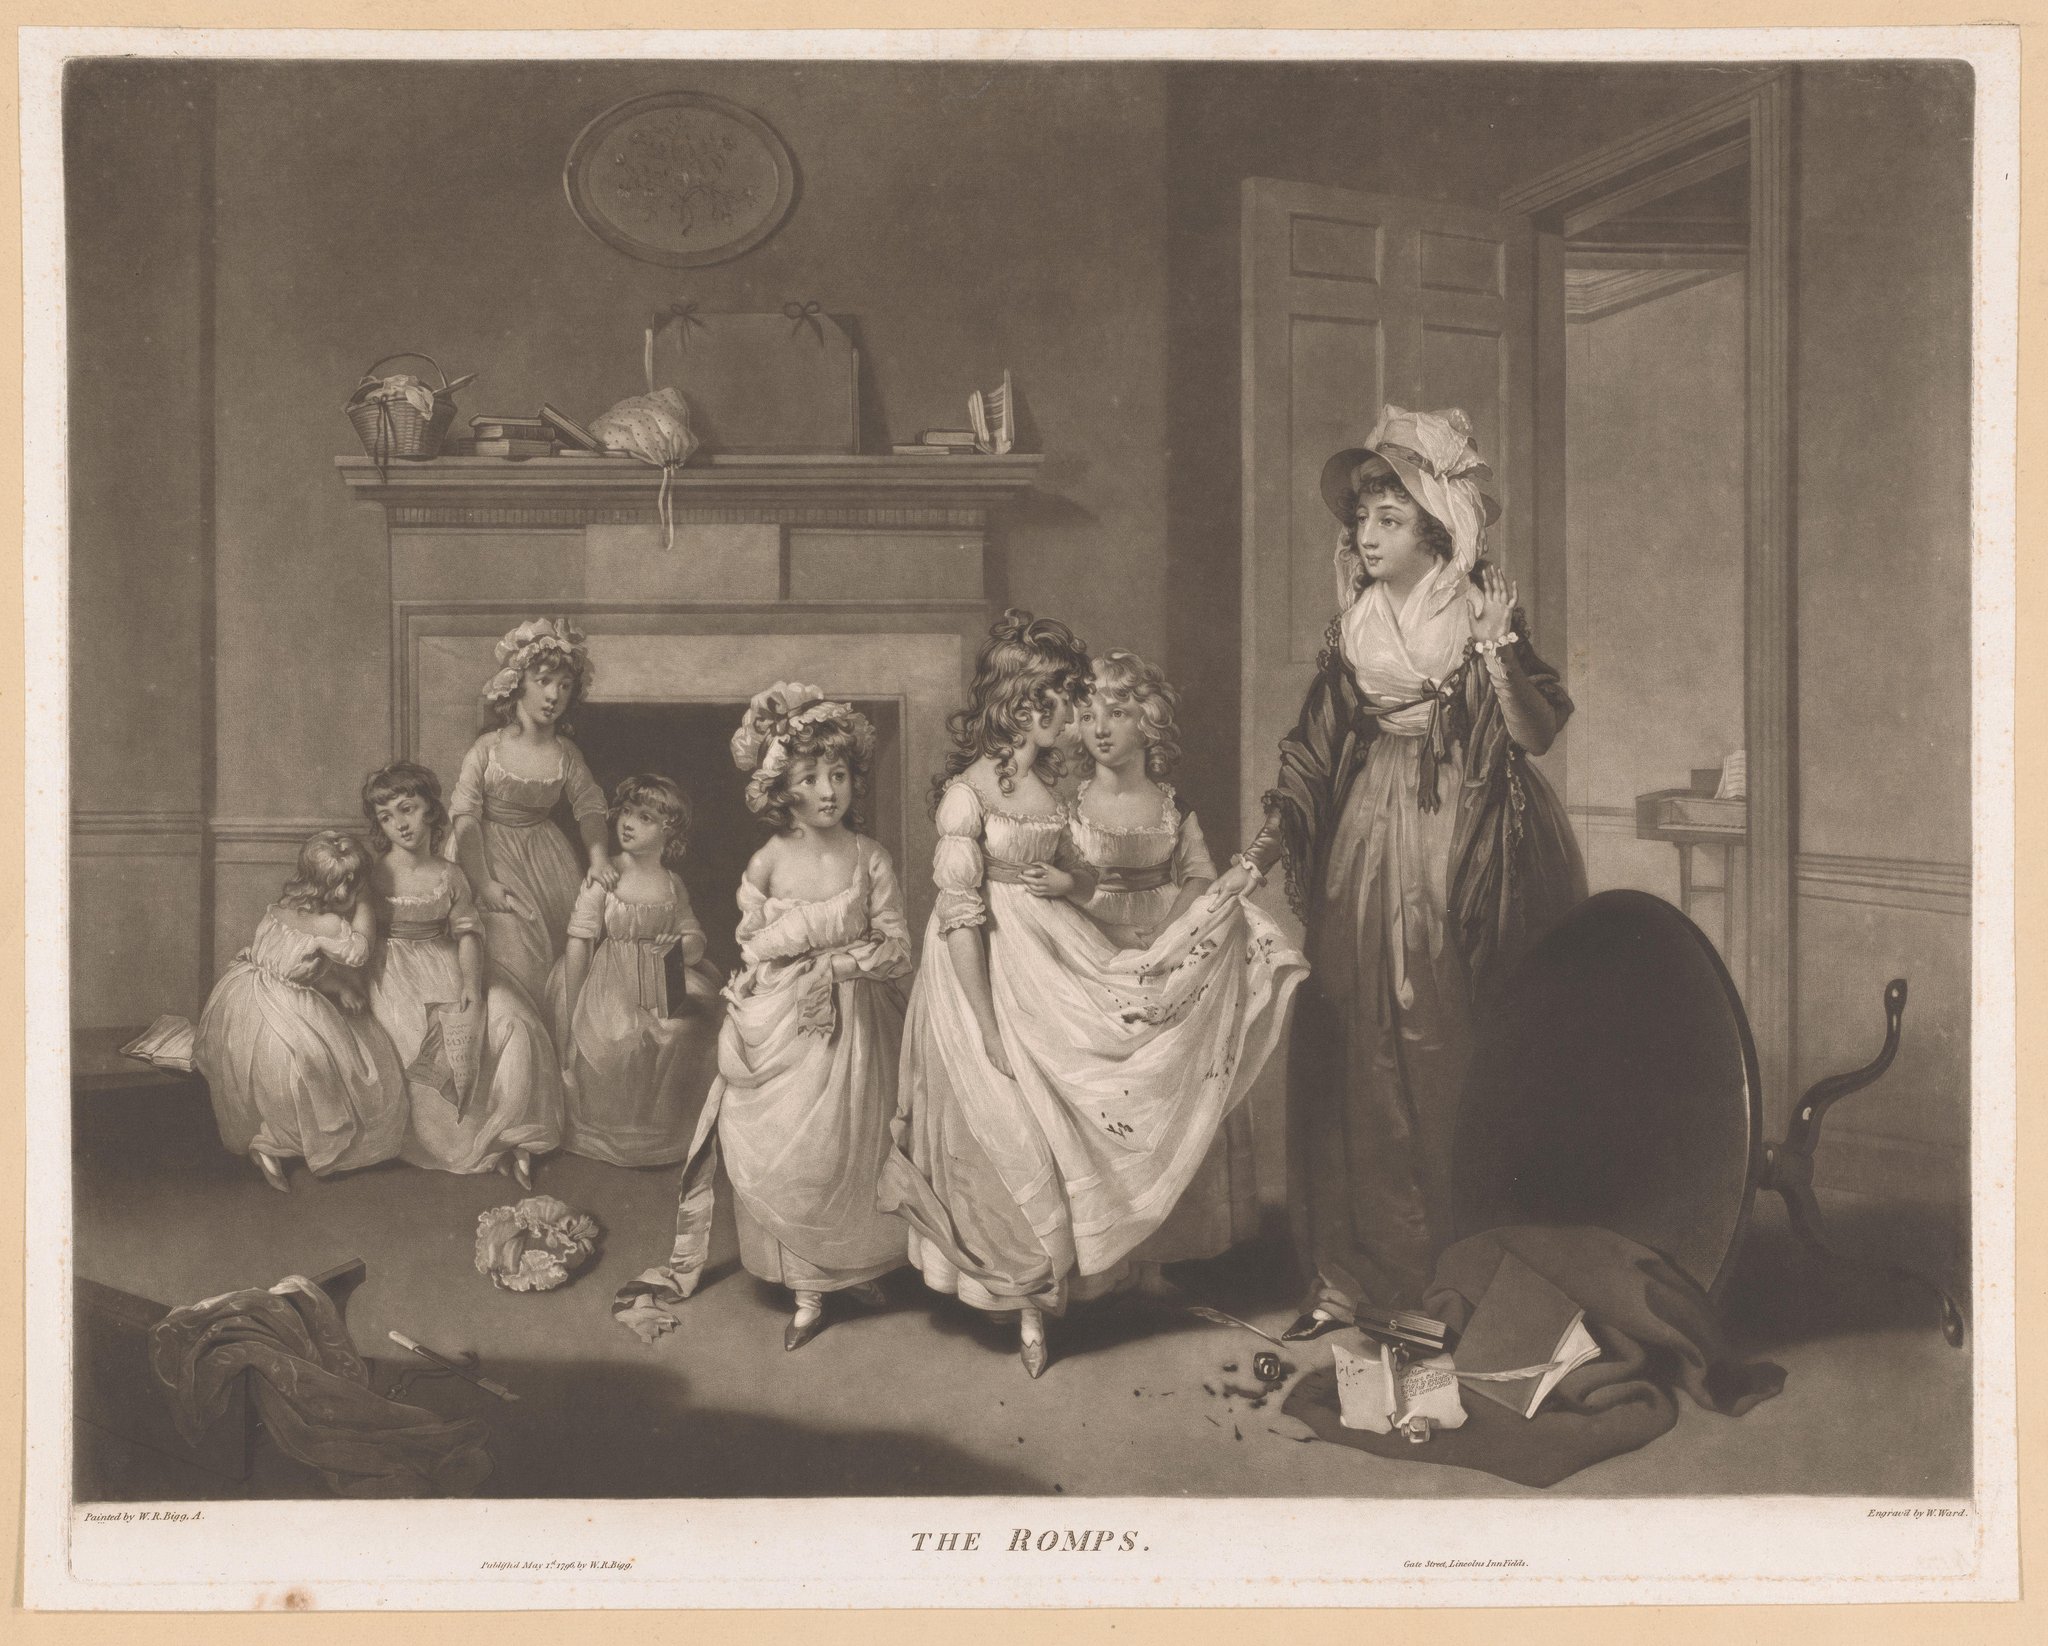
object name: print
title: Inkt over de jurk van één van de meisjes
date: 1796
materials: paper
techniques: etching, retroussage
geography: london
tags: ink-blot, container of ceramics: jar, jug, pot, vase, dress, gown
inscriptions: number: ‘N. 173’, collector's mark: Lugt 2228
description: Zeven meisjes en een vrouw naast een omgevallen tafel met schrijfwaren.